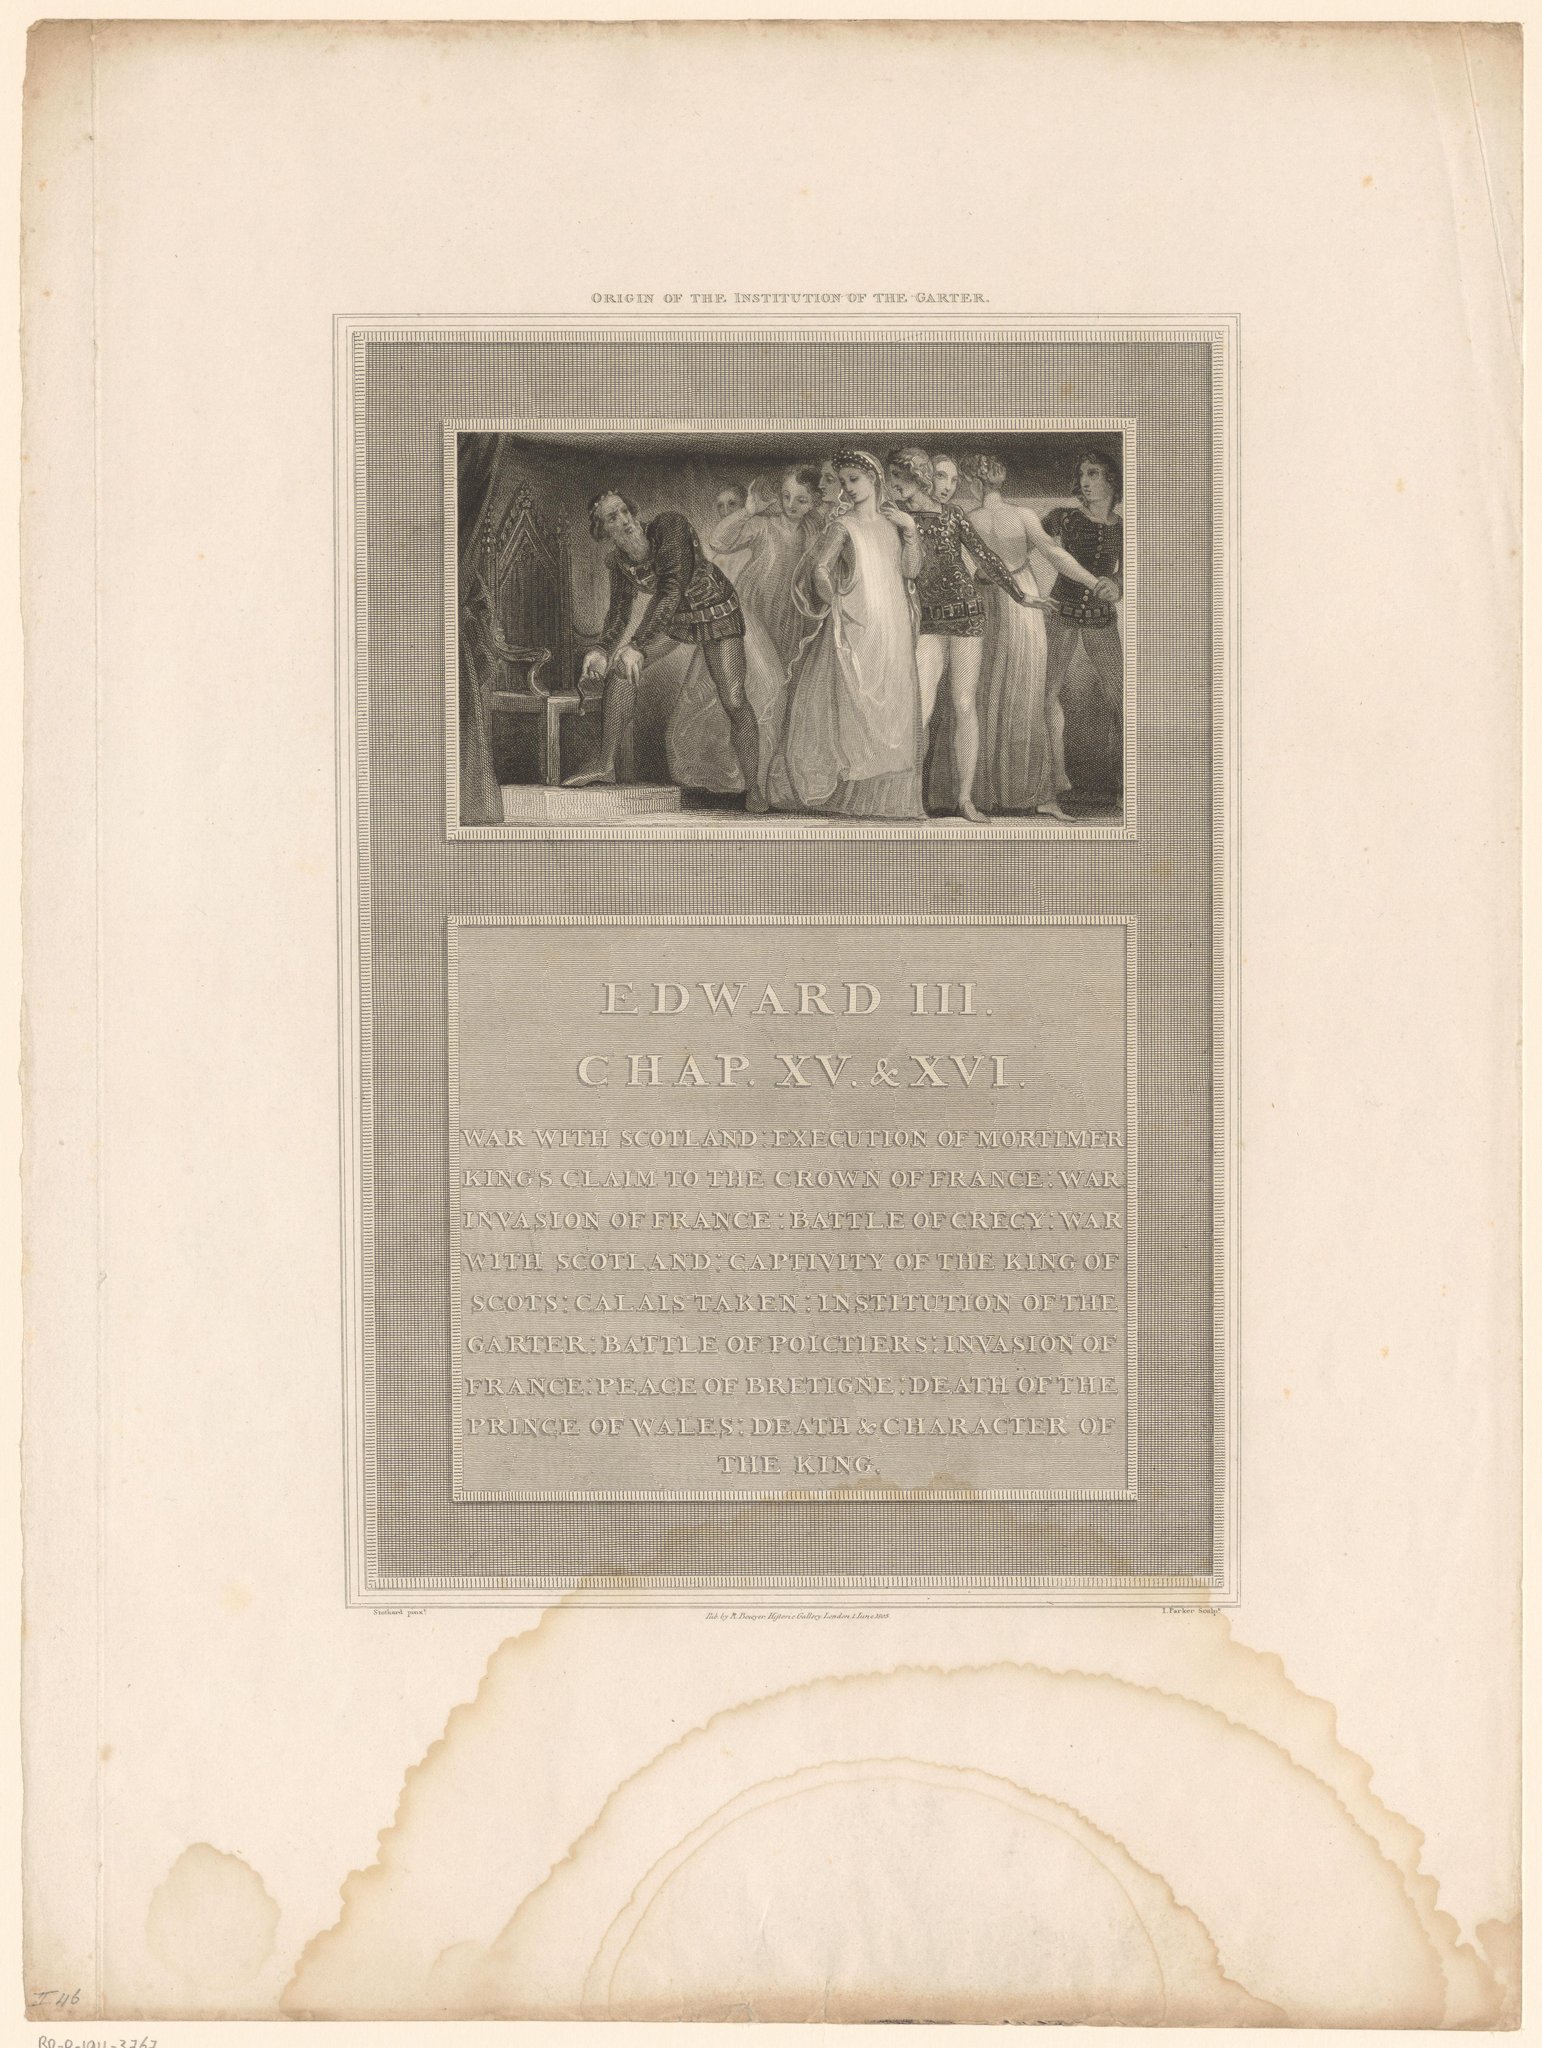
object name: print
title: Origin of the institution of the garter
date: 1805-1806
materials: paper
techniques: etching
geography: london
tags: knighthood order (garter)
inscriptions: collector's mark: Lugt 2228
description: De prenten uit deze serie zijn naar schilderijen uit Bowyer's Historic Gallery. Deze schilderijen en tekeningen illustreerden de gebeurtenissen uit David Hume's History of England. De prenten zijn daarom mogelijk gebruikt als illustratie in deze boeken.